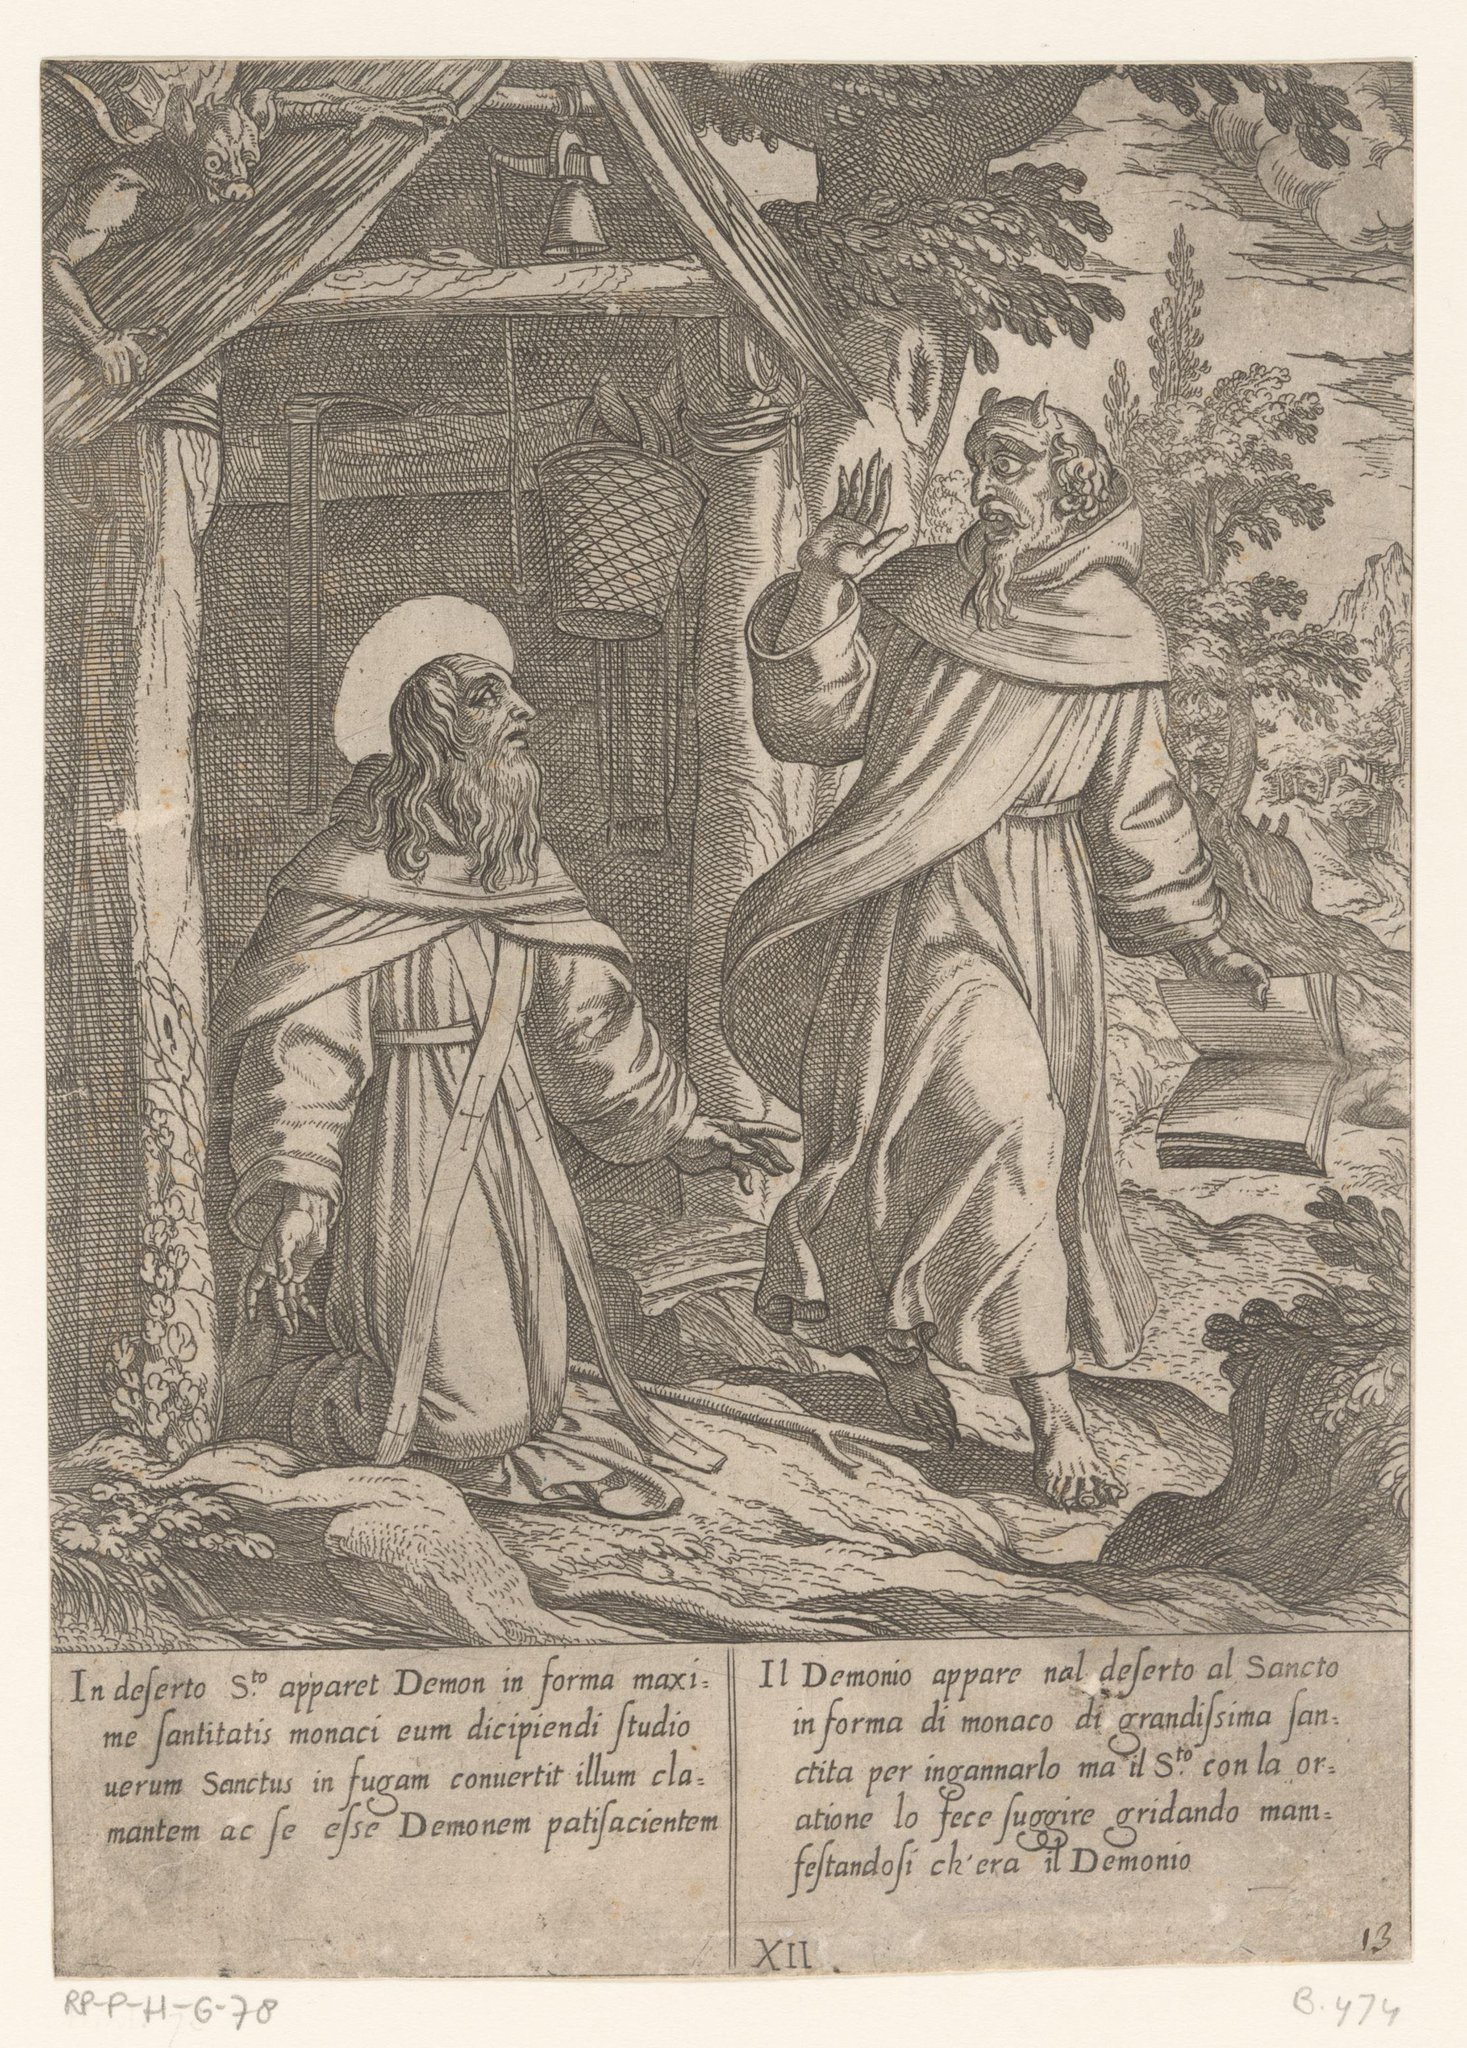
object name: print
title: H. Antonius in de wildernis bezocht door de duivel in monnikspij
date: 1598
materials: paper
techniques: etching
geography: rome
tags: devil(s) and demons, the hermit antony abbot (antonius abbas) of egypt, also called the great; possible attributes: bell, book, t-shaped staff, flames, pig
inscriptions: number: ‘13’, collector's mark: ‘Hinloopen’, collector's mark: Lugt 11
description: Deze prent maakt deel uit van een reeks van 27 prenten (+ titelprent) over het leven van de heilige Antonius, naar een frescocyclus in de S. Antonio Abbate in Rome door Giovanni Battista Lombardelli en Niccolò Circignani.